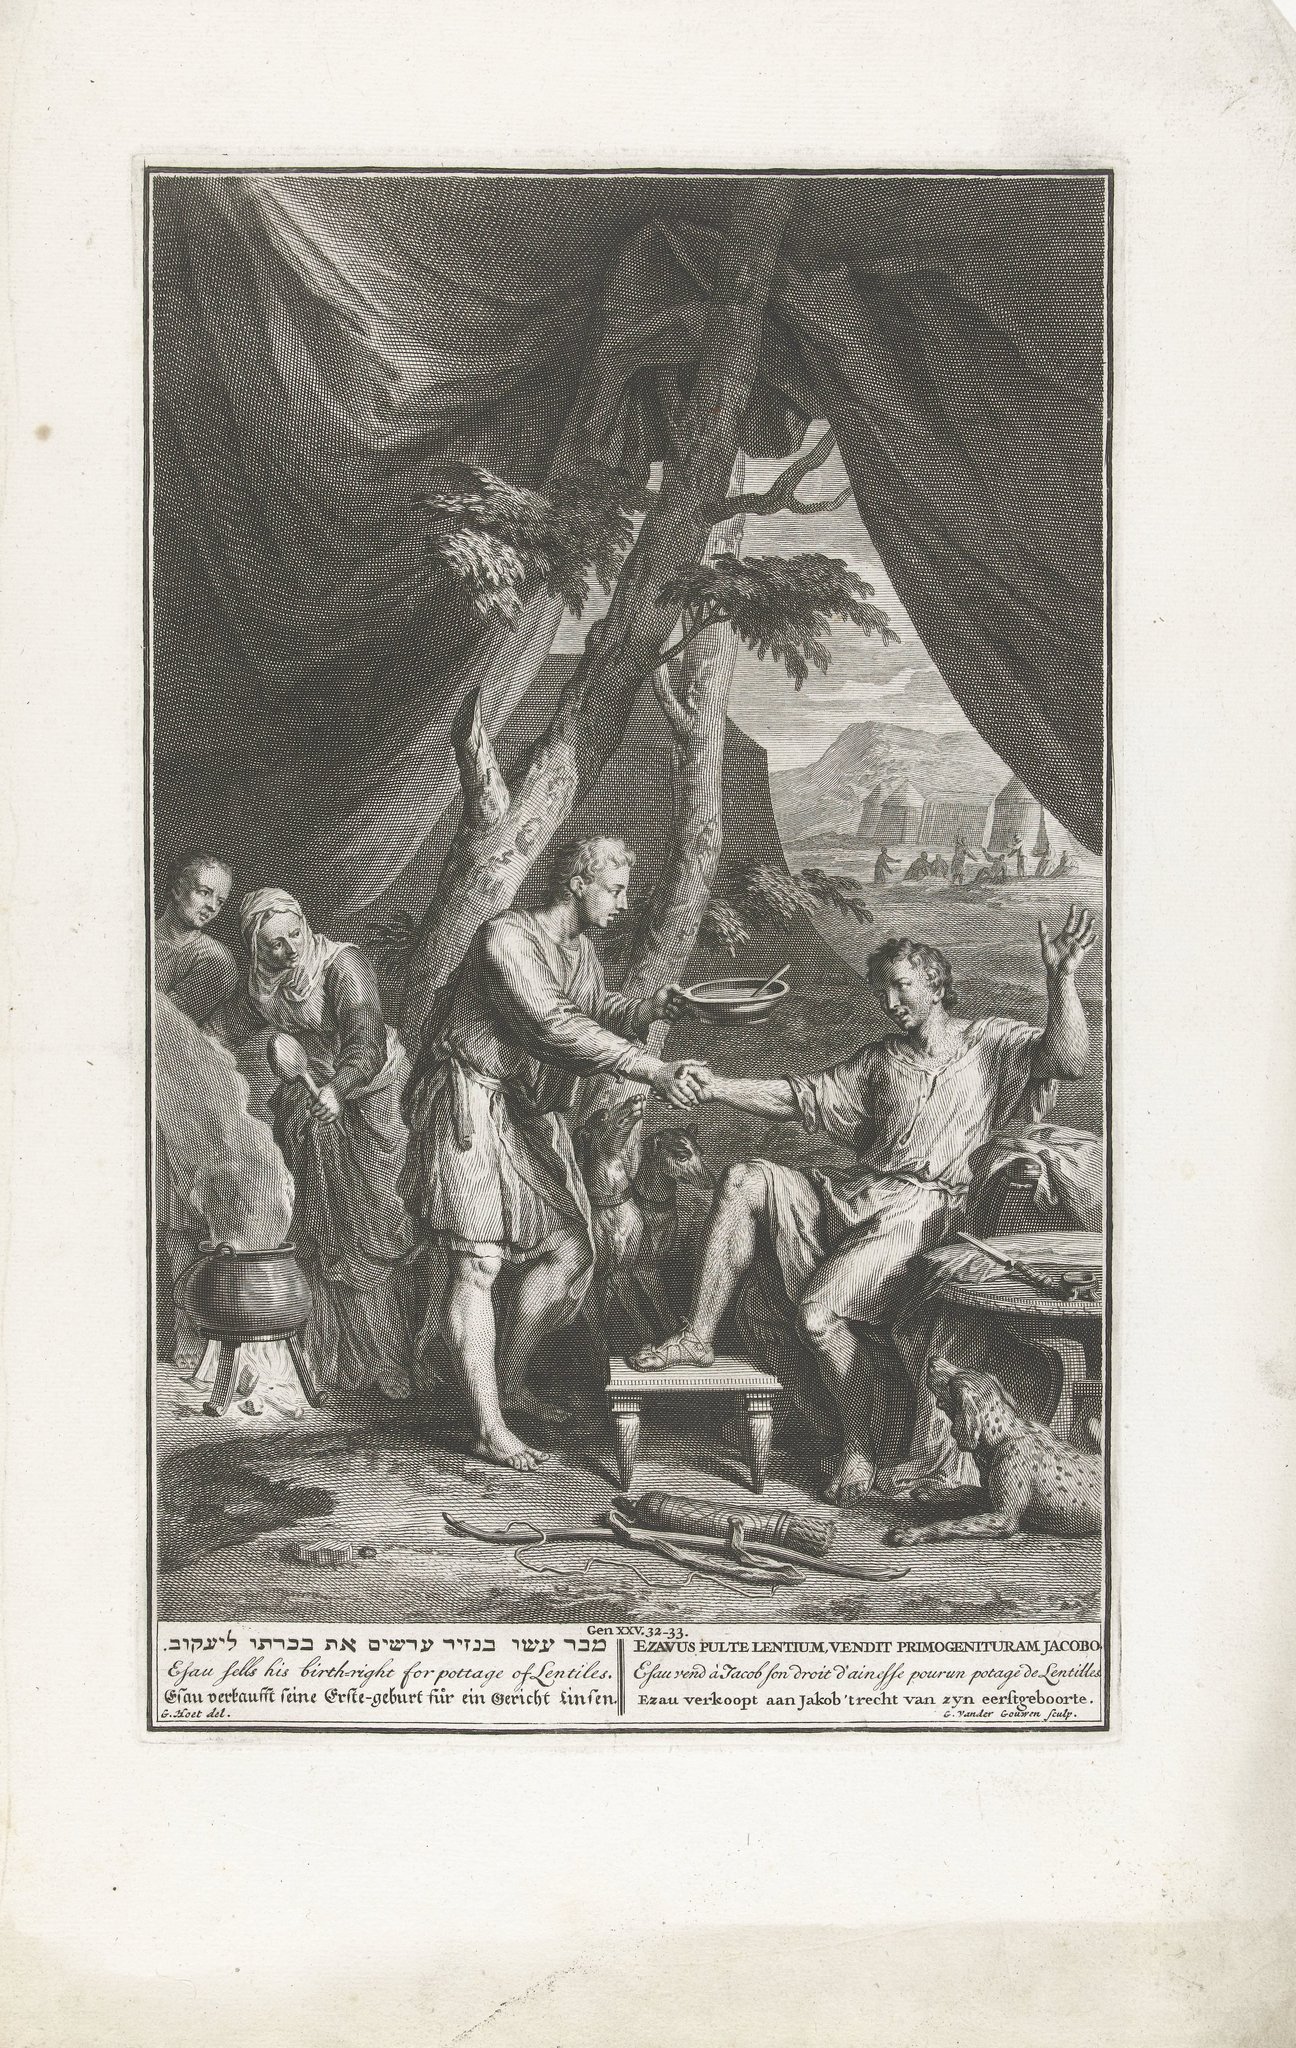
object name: book illustration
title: Esau verkoopt zijn eerstgeboorterecht aan Jakob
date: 1728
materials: paper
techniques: engraving, etching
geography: amsterdam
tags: esau, returning hungry from the hunt, sells his first birthright to jacob for a pottage of lentils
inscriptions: inscription: ‘utrechts Fundatie huijs’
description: Esau verkoopt zijn eerstgeboorterecht aan Jakob voor een bord linzen. Jakob overhandigt hem het bord (Gen. 25:32-33). De prent heeft een Hebreeuws, Latijns, Frans, Engels, Duits en Nederlands onderschrift.